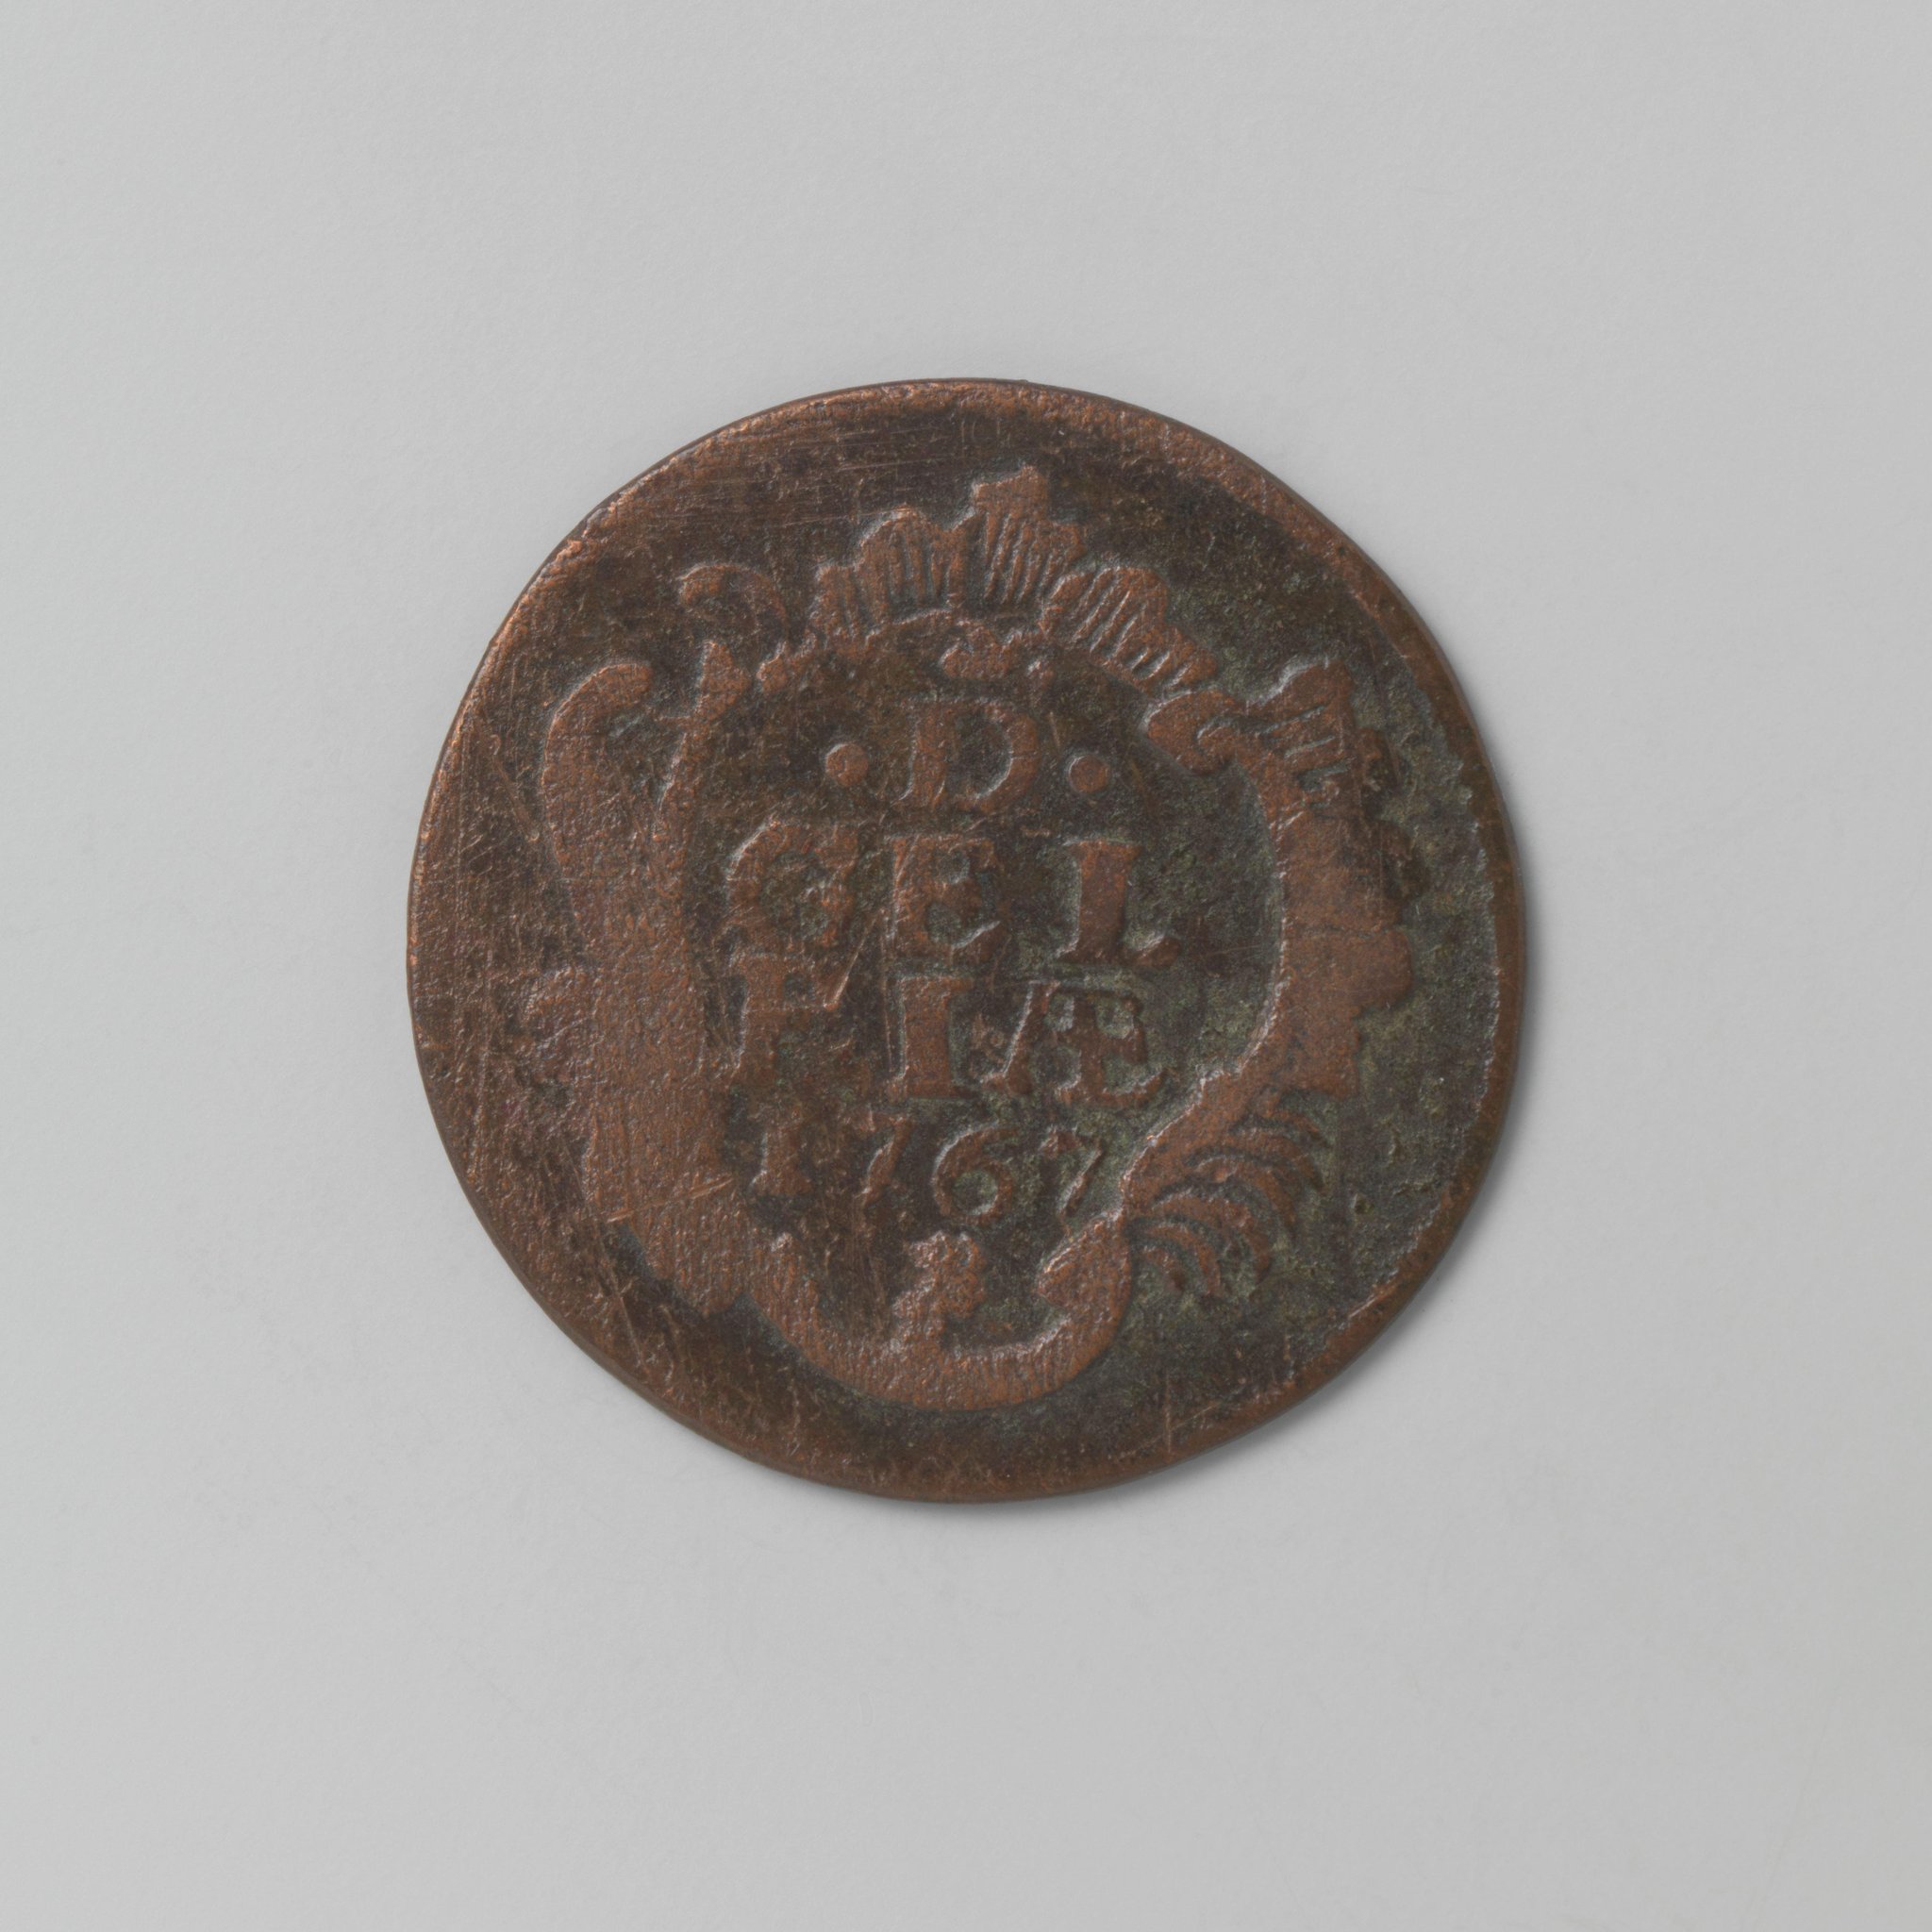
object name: duit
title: Gelderland, duit, 1767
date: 1767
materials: copper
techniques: striking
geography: harderwijk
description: Koperen munt. Voorzijde: binnen weelderige rococo-versiering in drie regels D/GEL/RIAE, daaronder jaartal en muntmeesterteken. Keerzijde: gekroond Gelders wapenschild.